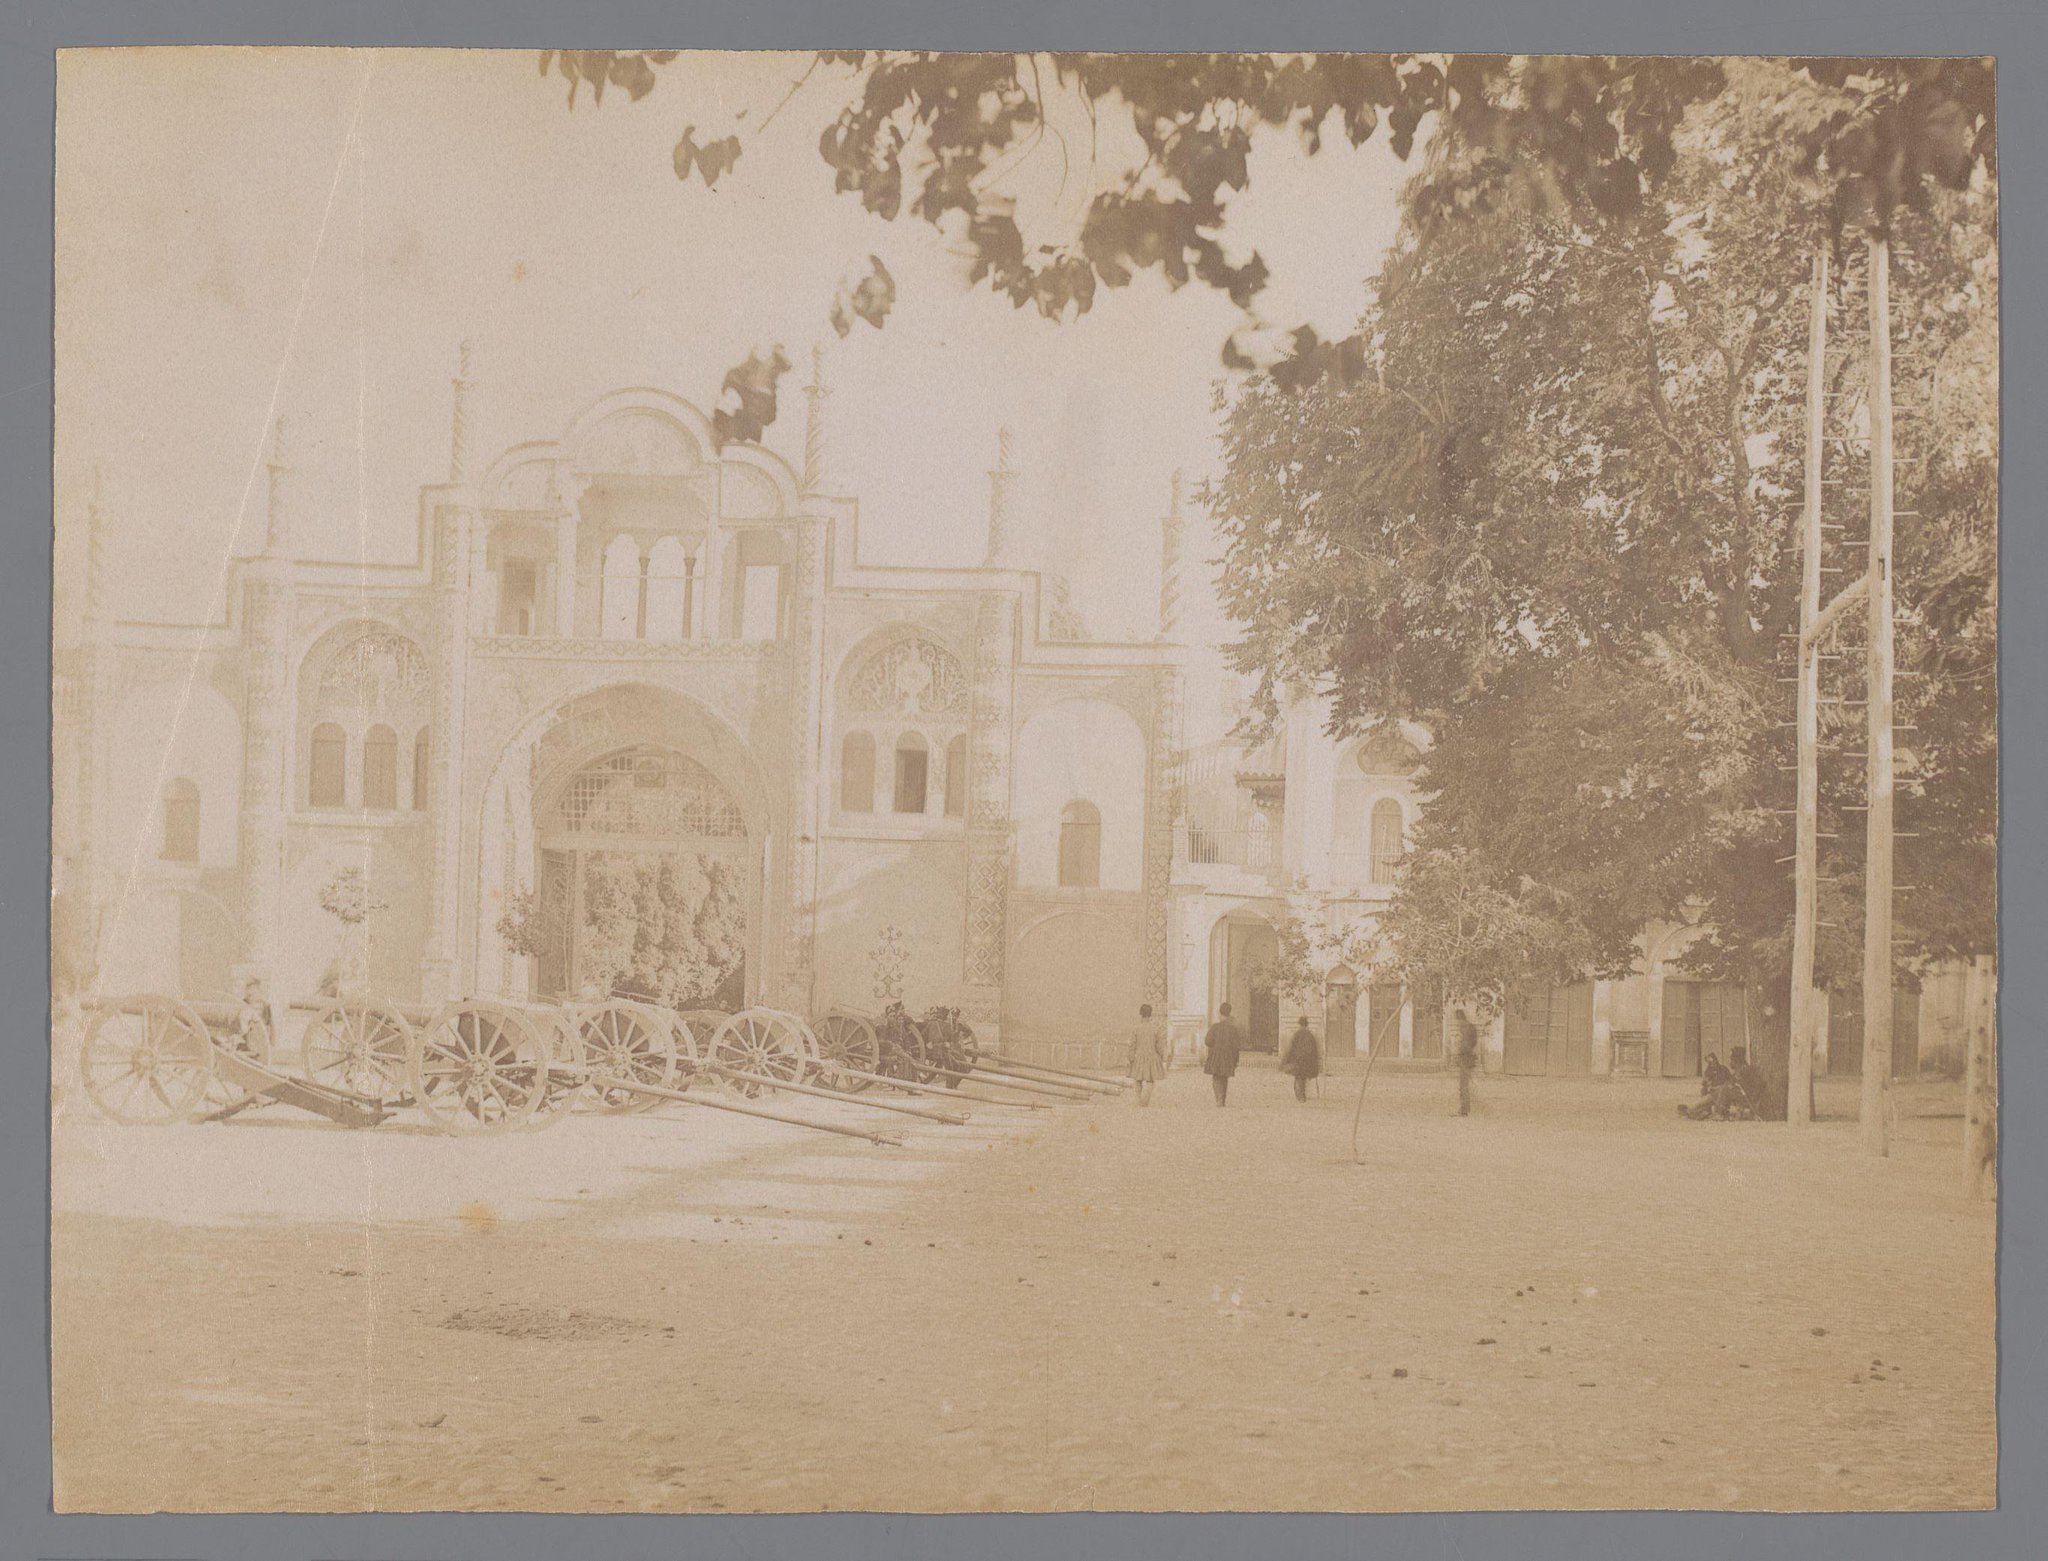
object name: photograph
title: Paleis [?] ("Topkaneh, Teheran"), Teheran, Iran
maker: antoine sevruguin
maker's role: fotograaf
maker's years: 1840-1933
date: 1880-1910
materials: paper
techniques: albumen print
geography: iran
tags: teheran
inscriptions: inscription: ‘Teheran, Topkaneh’, number: ‘12’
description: Paleis [?] ("Topkaneh, Teheran"), Teheran, Iran.